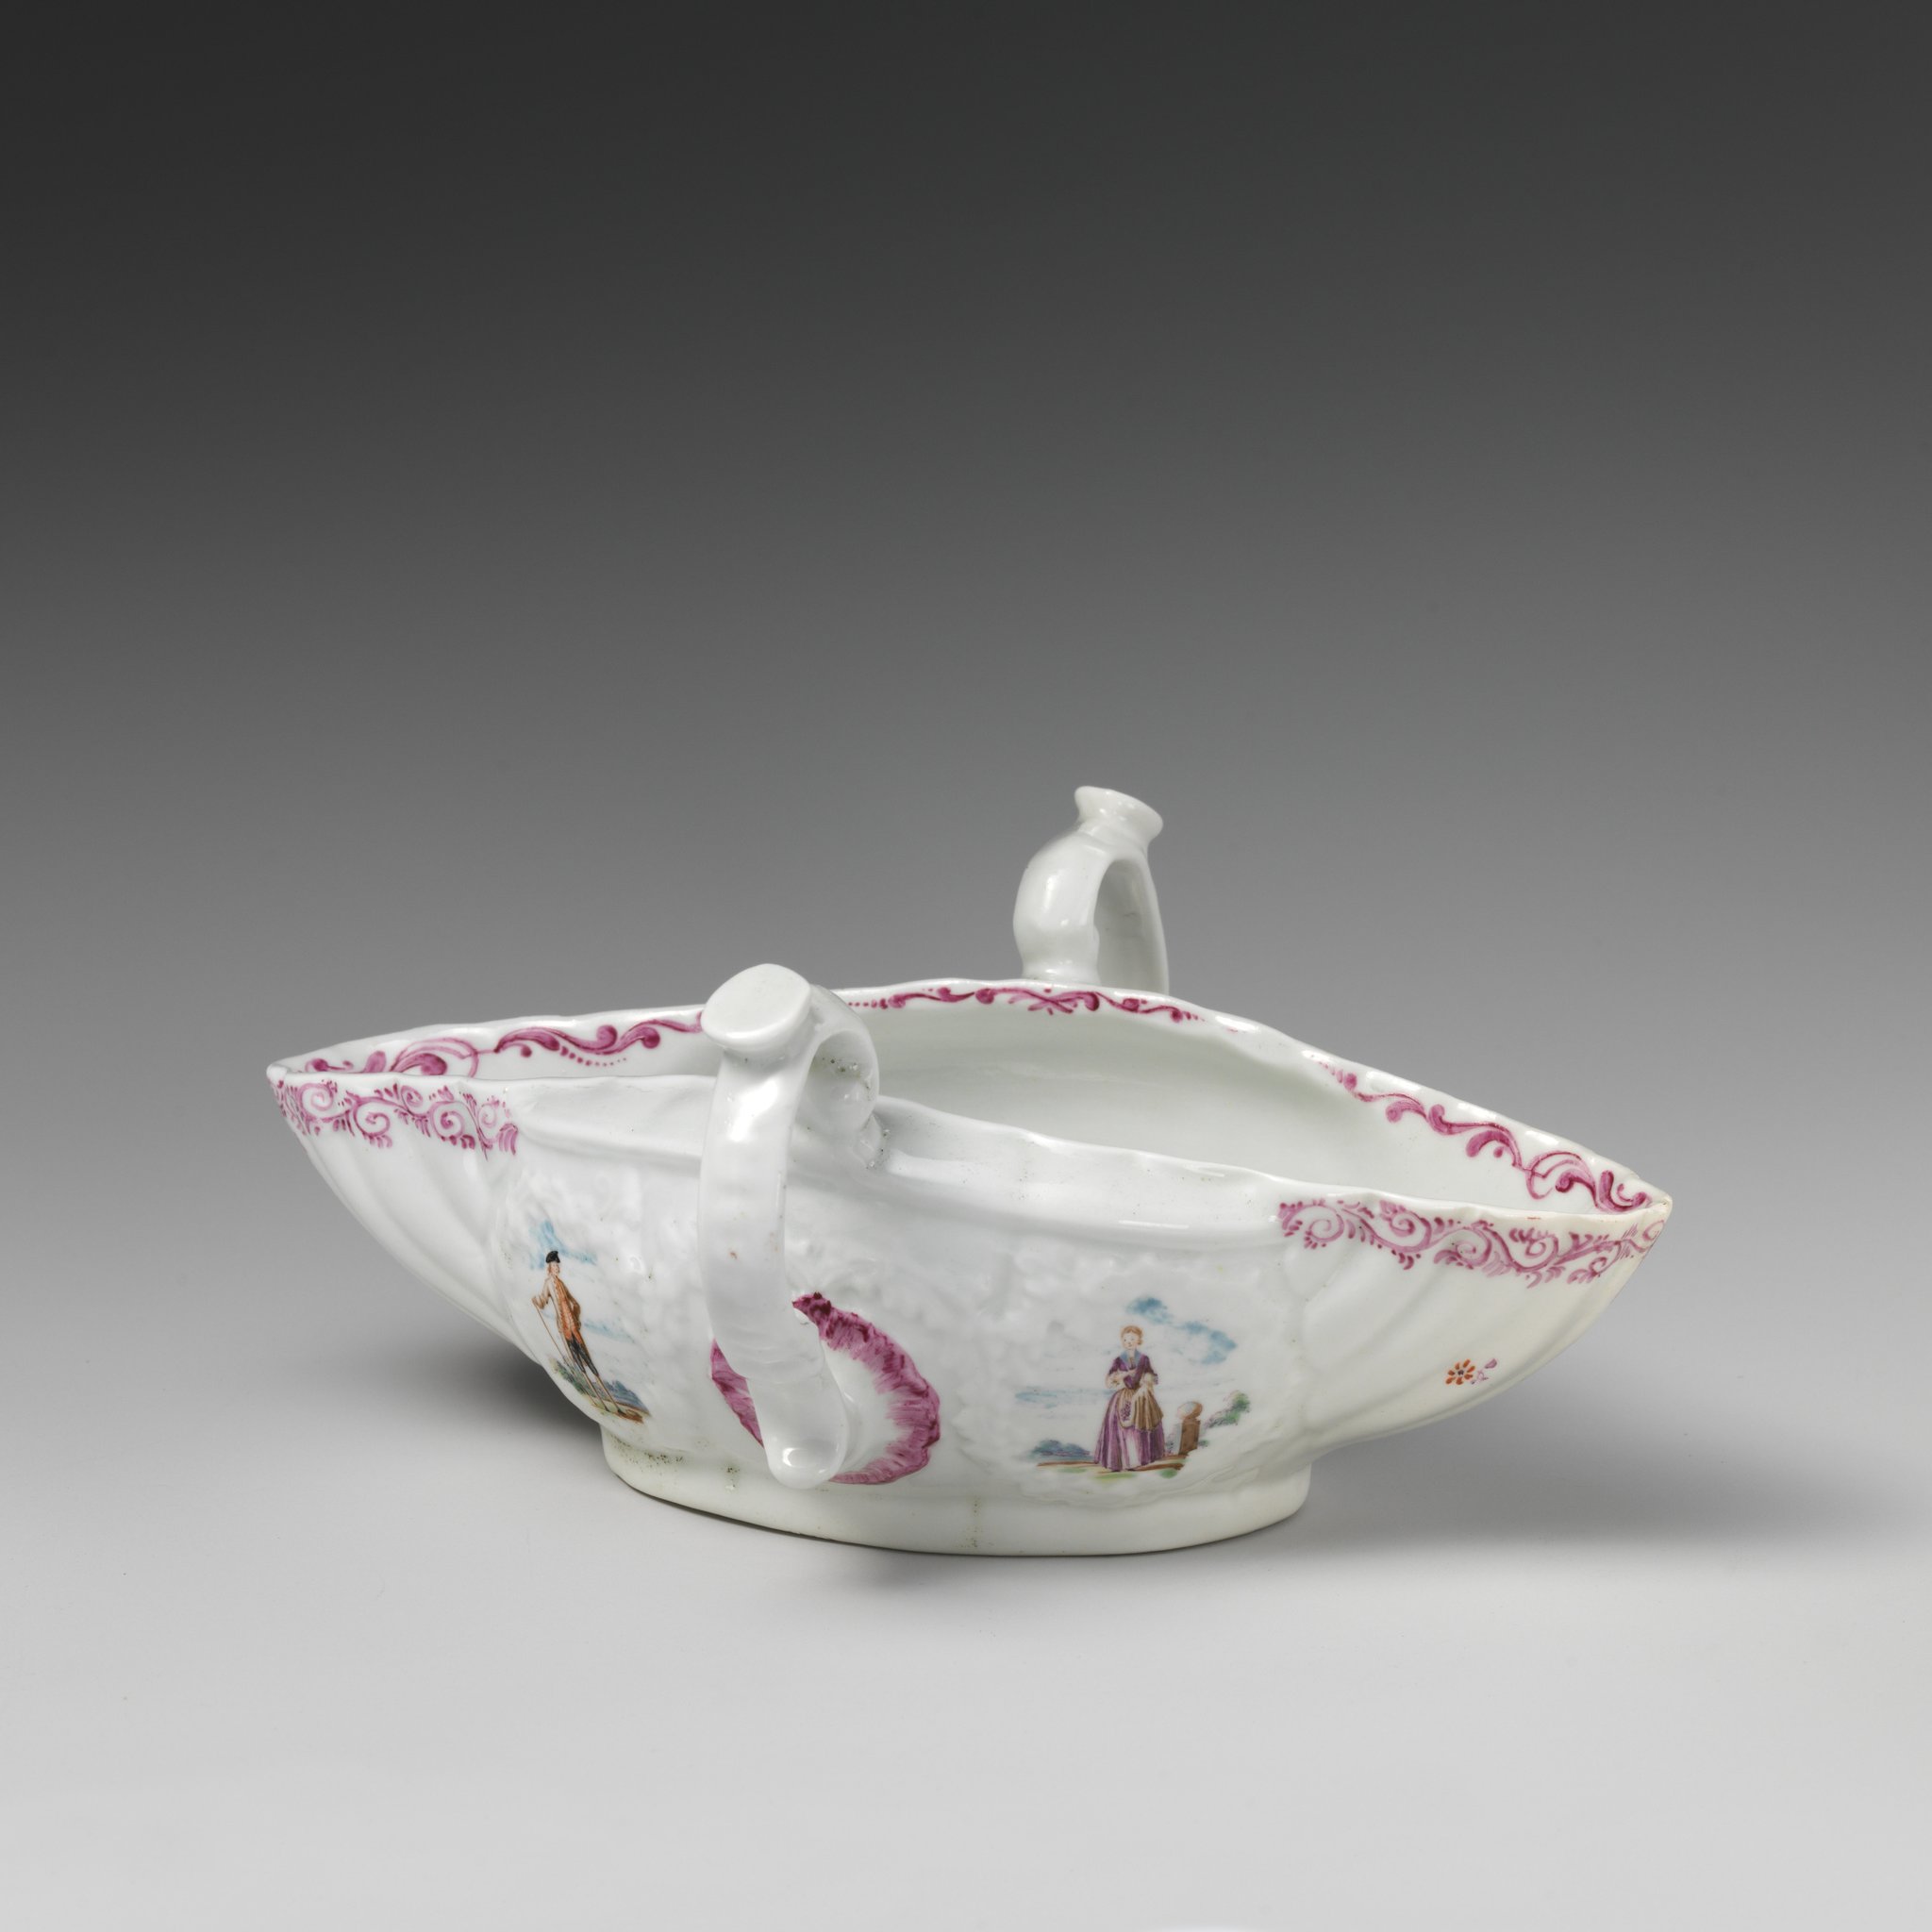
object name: sauceboat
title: Sauceboat (one of a pair)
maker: worcester factory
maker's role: factory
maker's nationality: british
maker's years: 1751-2008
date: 1755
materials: soft paste porcelain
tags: human figures